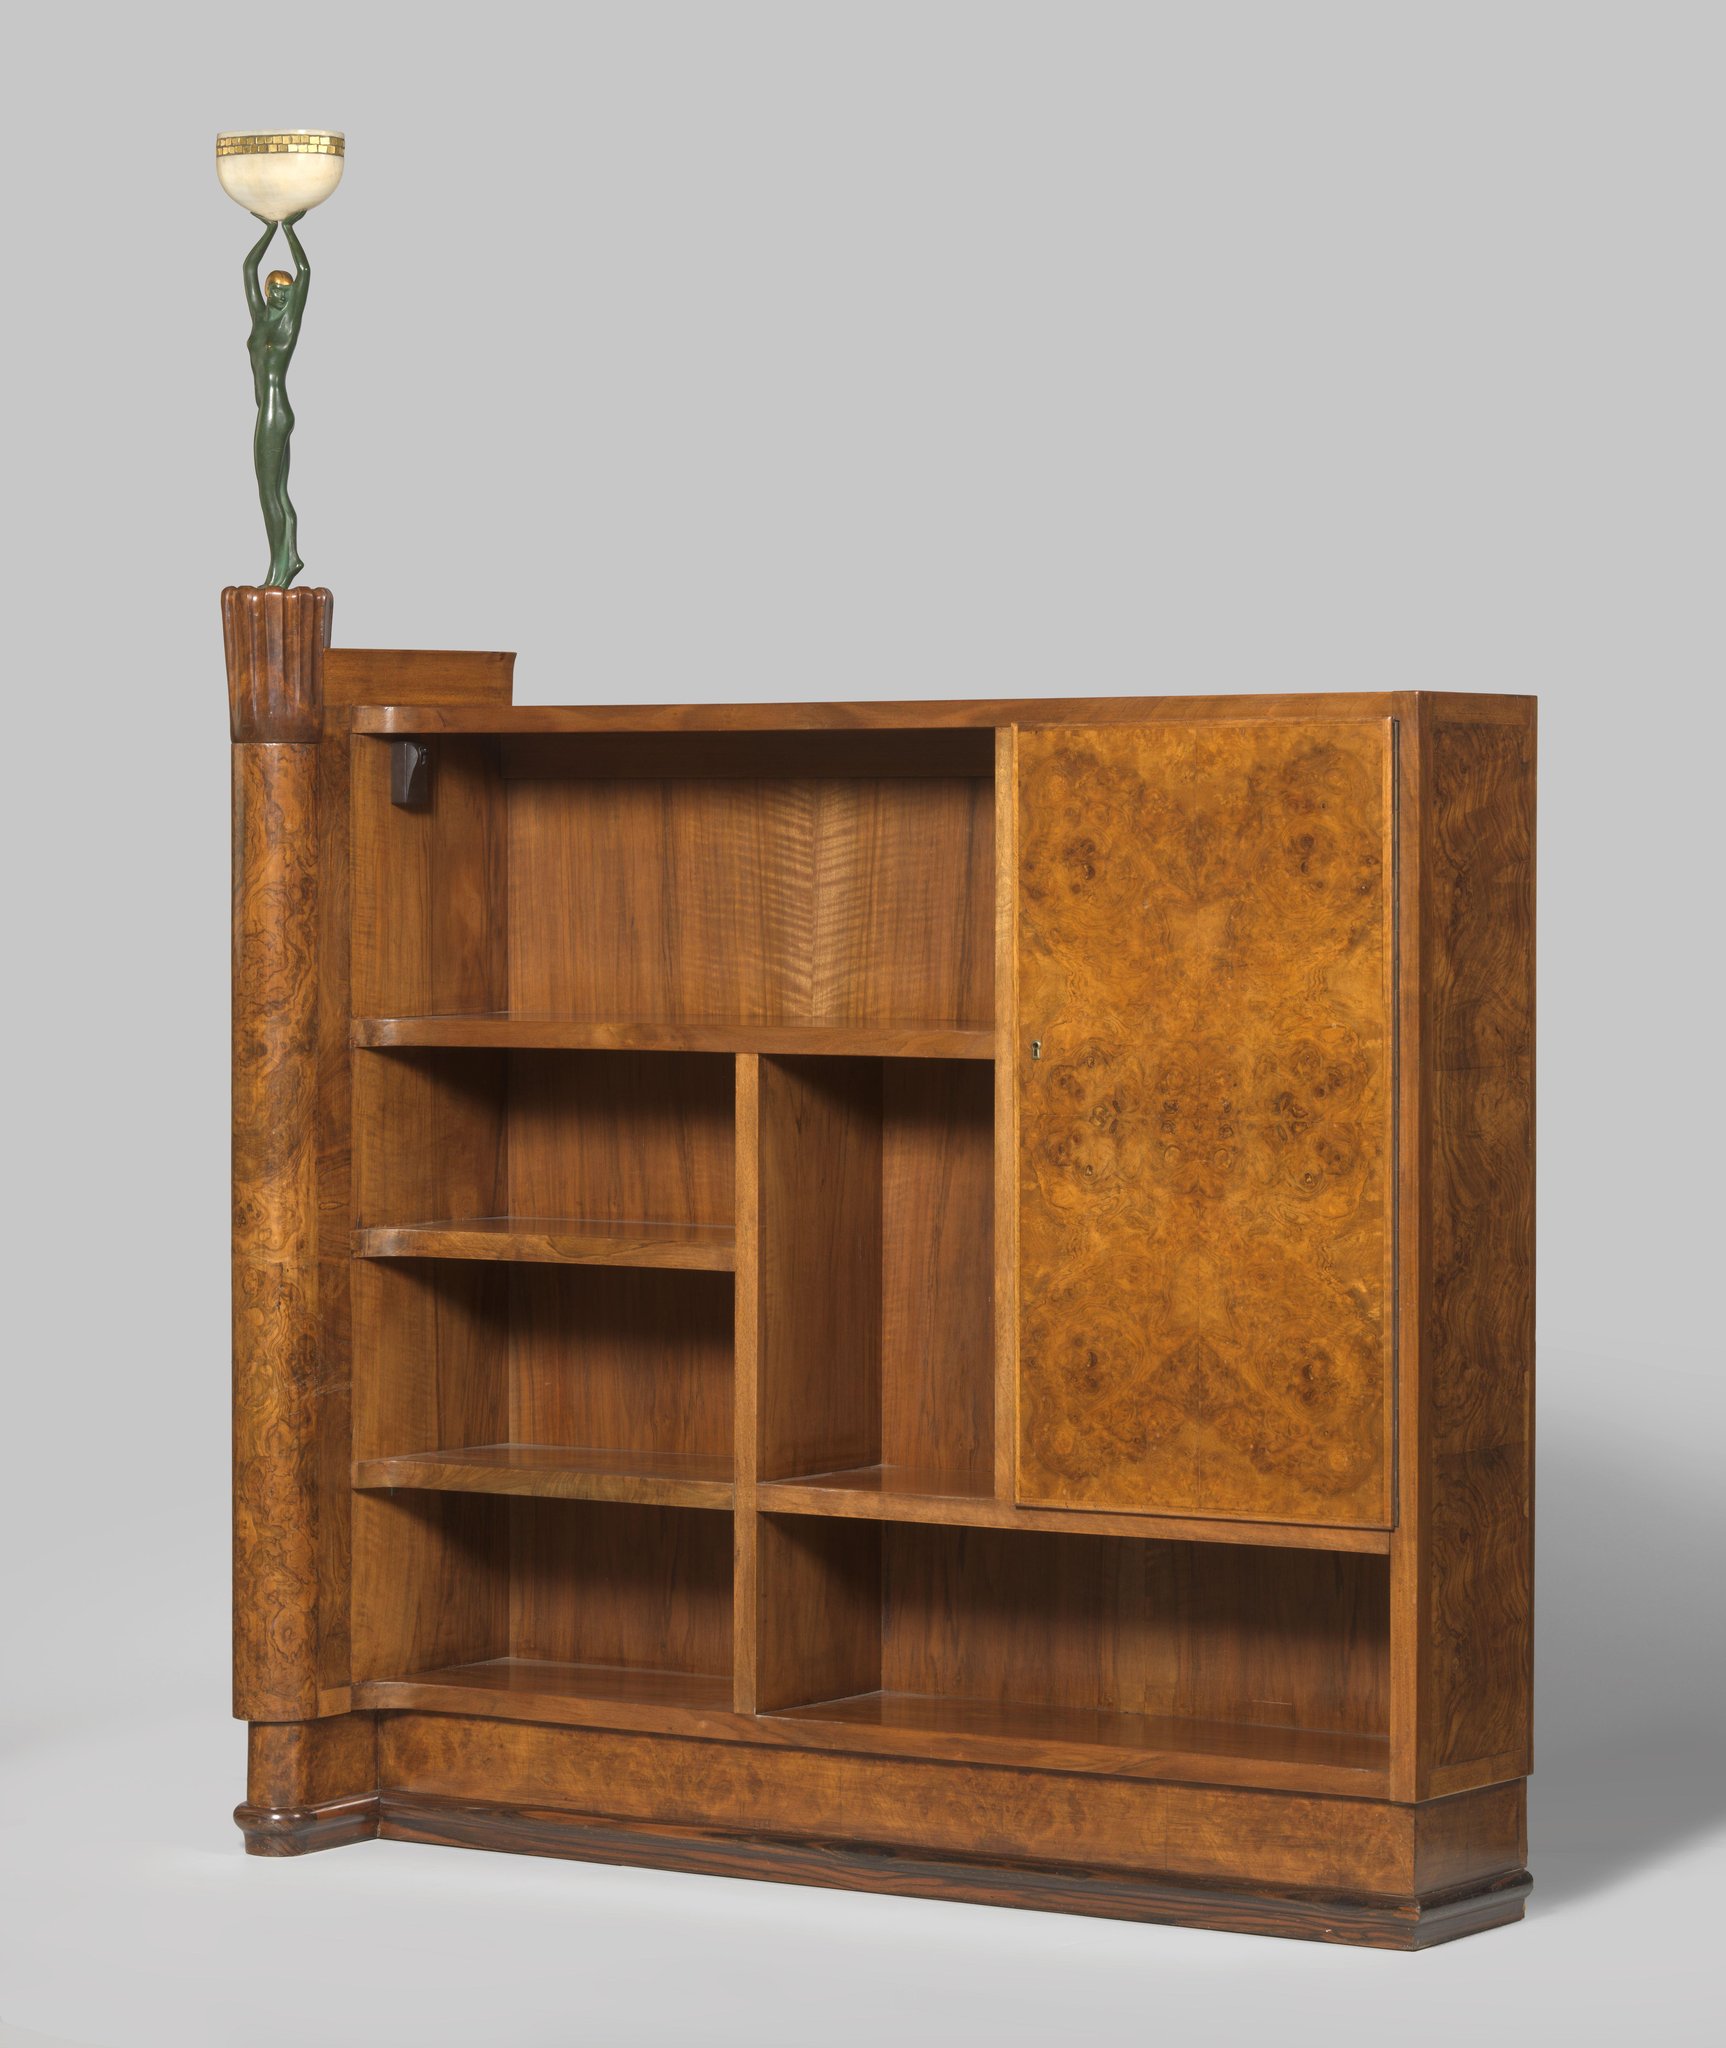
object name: lamp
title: Lichtarmatuur in vorm van vrouw met kom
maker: jan de meijer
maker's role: designer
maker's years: 1878-1950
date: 1930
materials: glass, metal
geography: northern netherlands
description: Een metalen lichtarmatuur in de vorm van een vrouw, die een glazen kom omhoog houdt